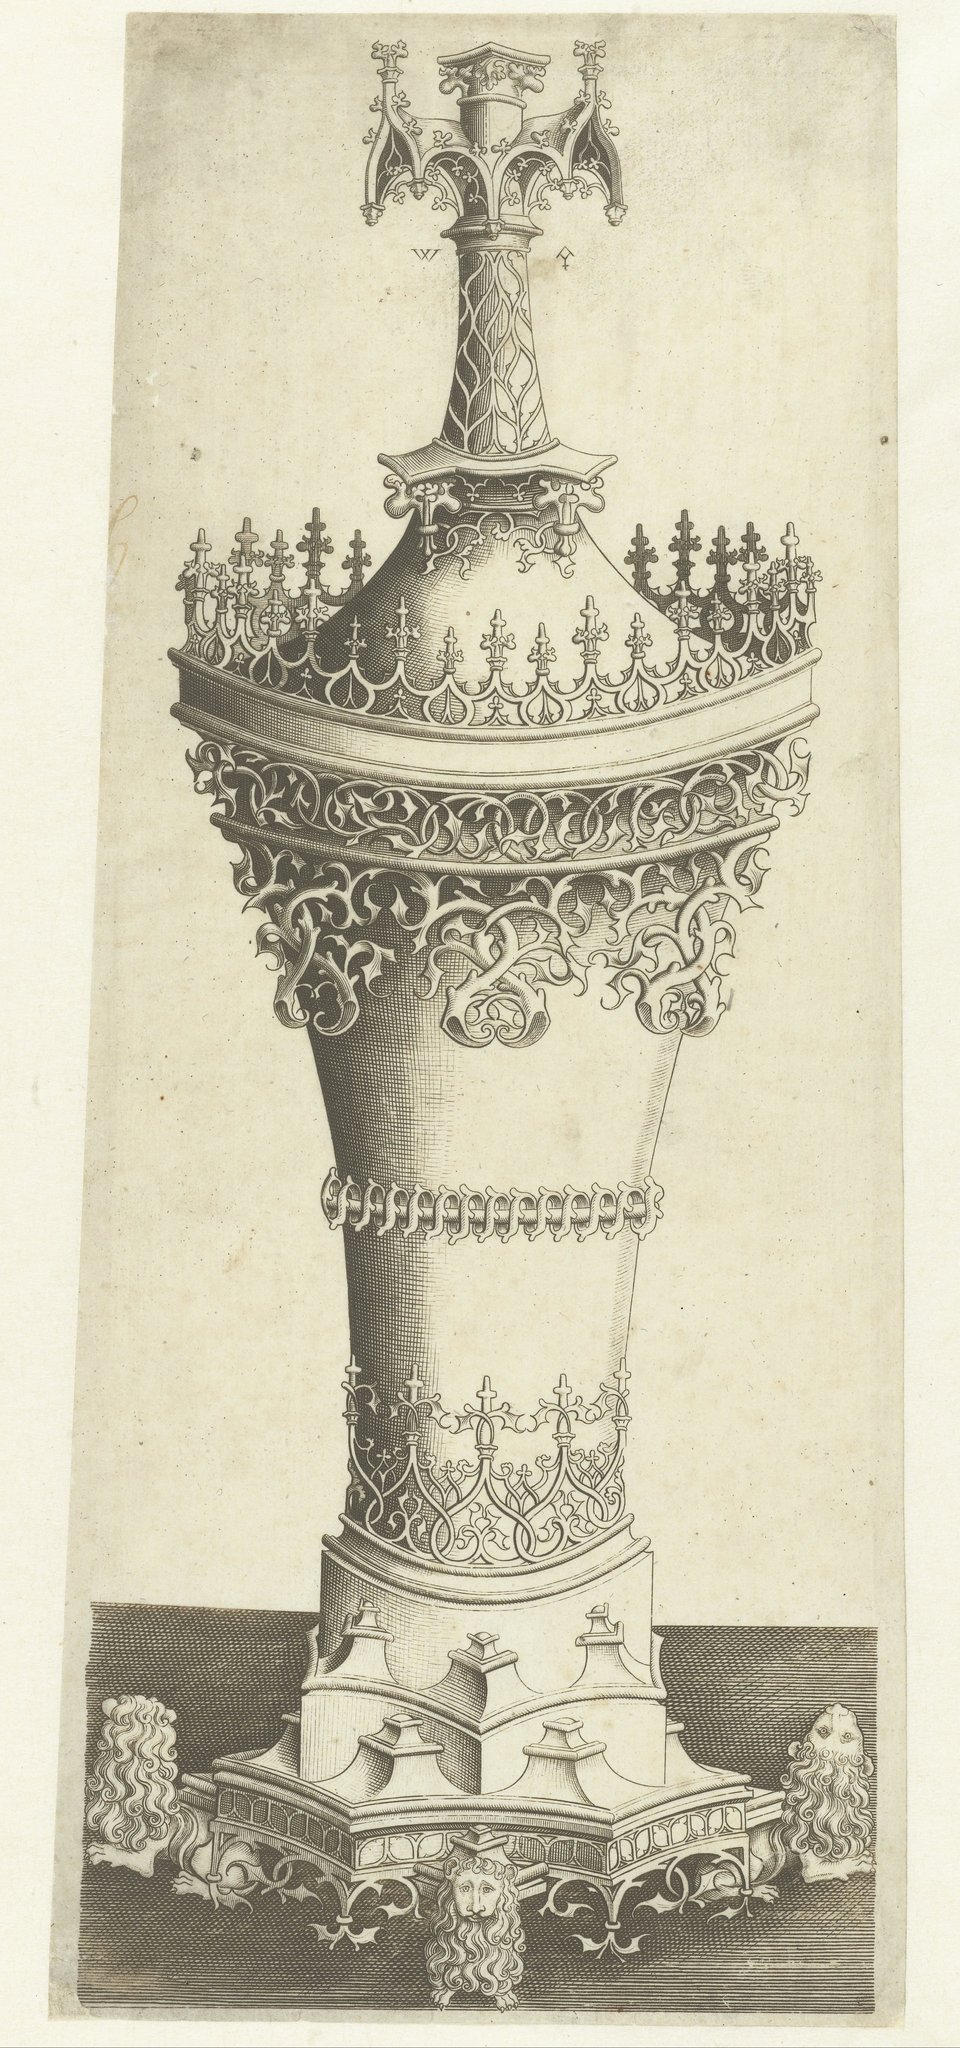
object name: print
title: Gotische bokaal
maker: Anonymous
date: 1465-1535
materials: paper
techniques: engraving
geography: low countries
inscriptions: collector's mark: Lugt 2228